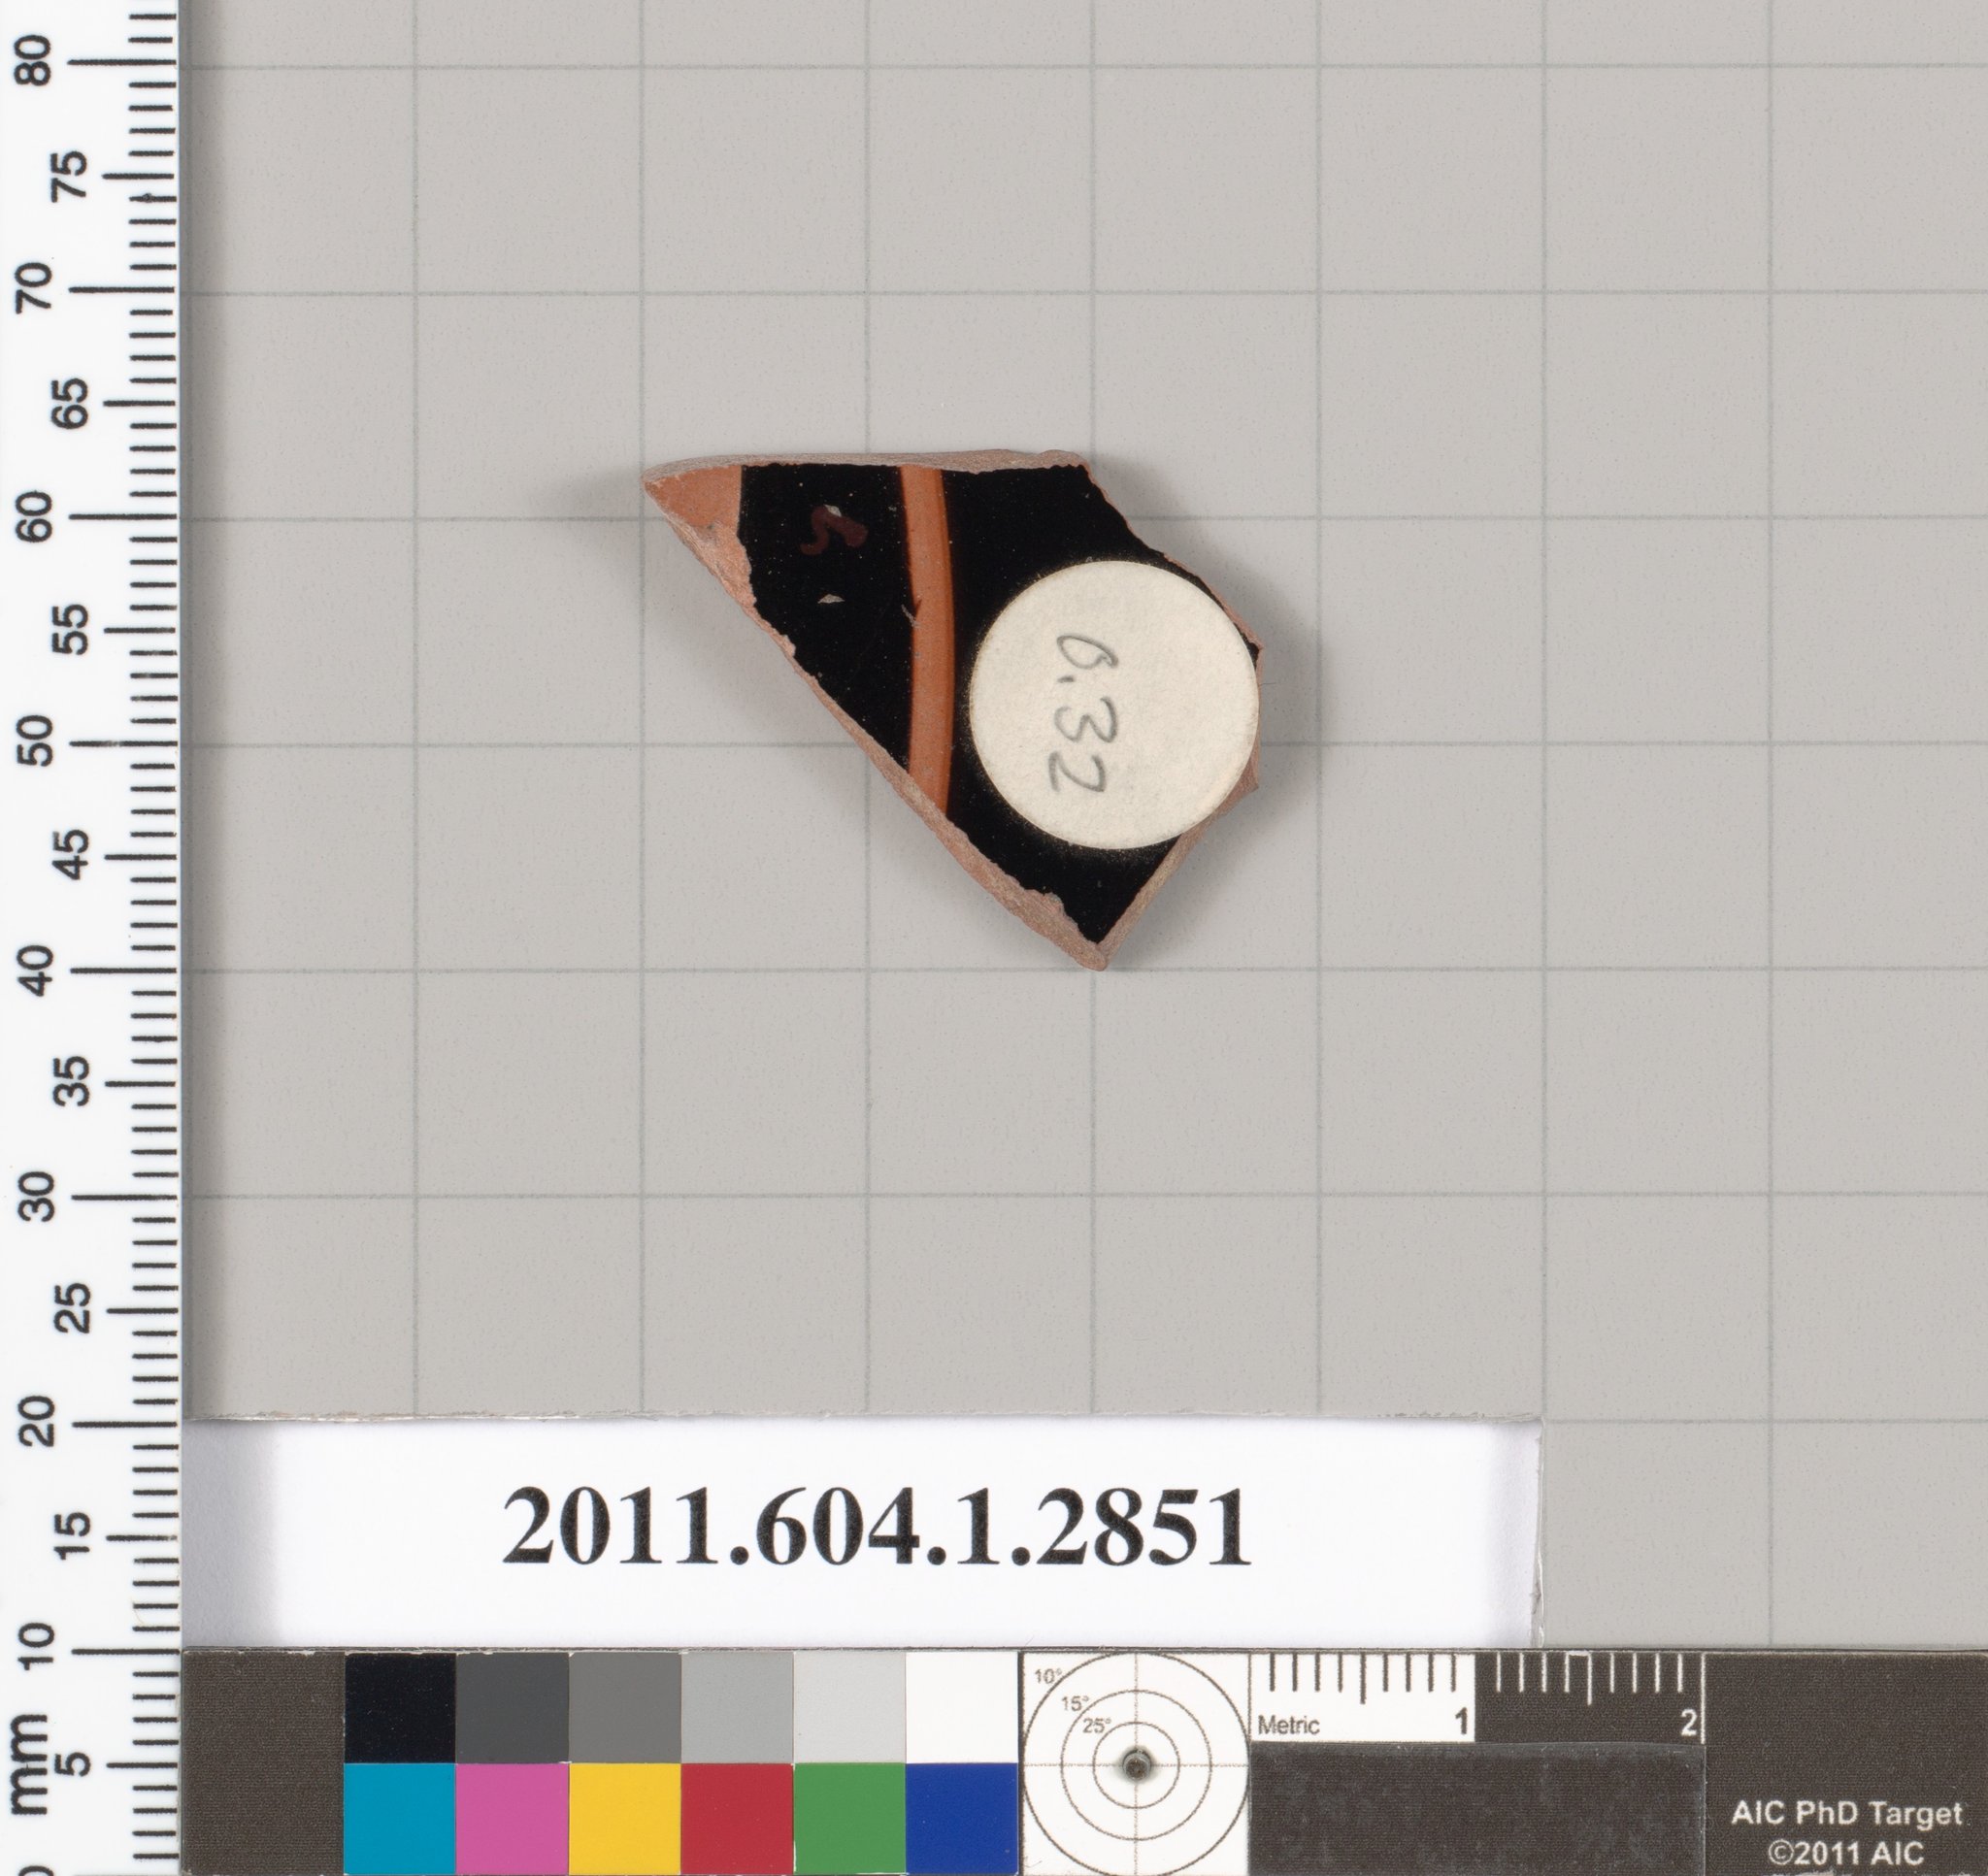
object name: kylix fragment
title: Terracotta fragment of a kylix (drinking cup)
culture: greek, attic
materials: terracotta